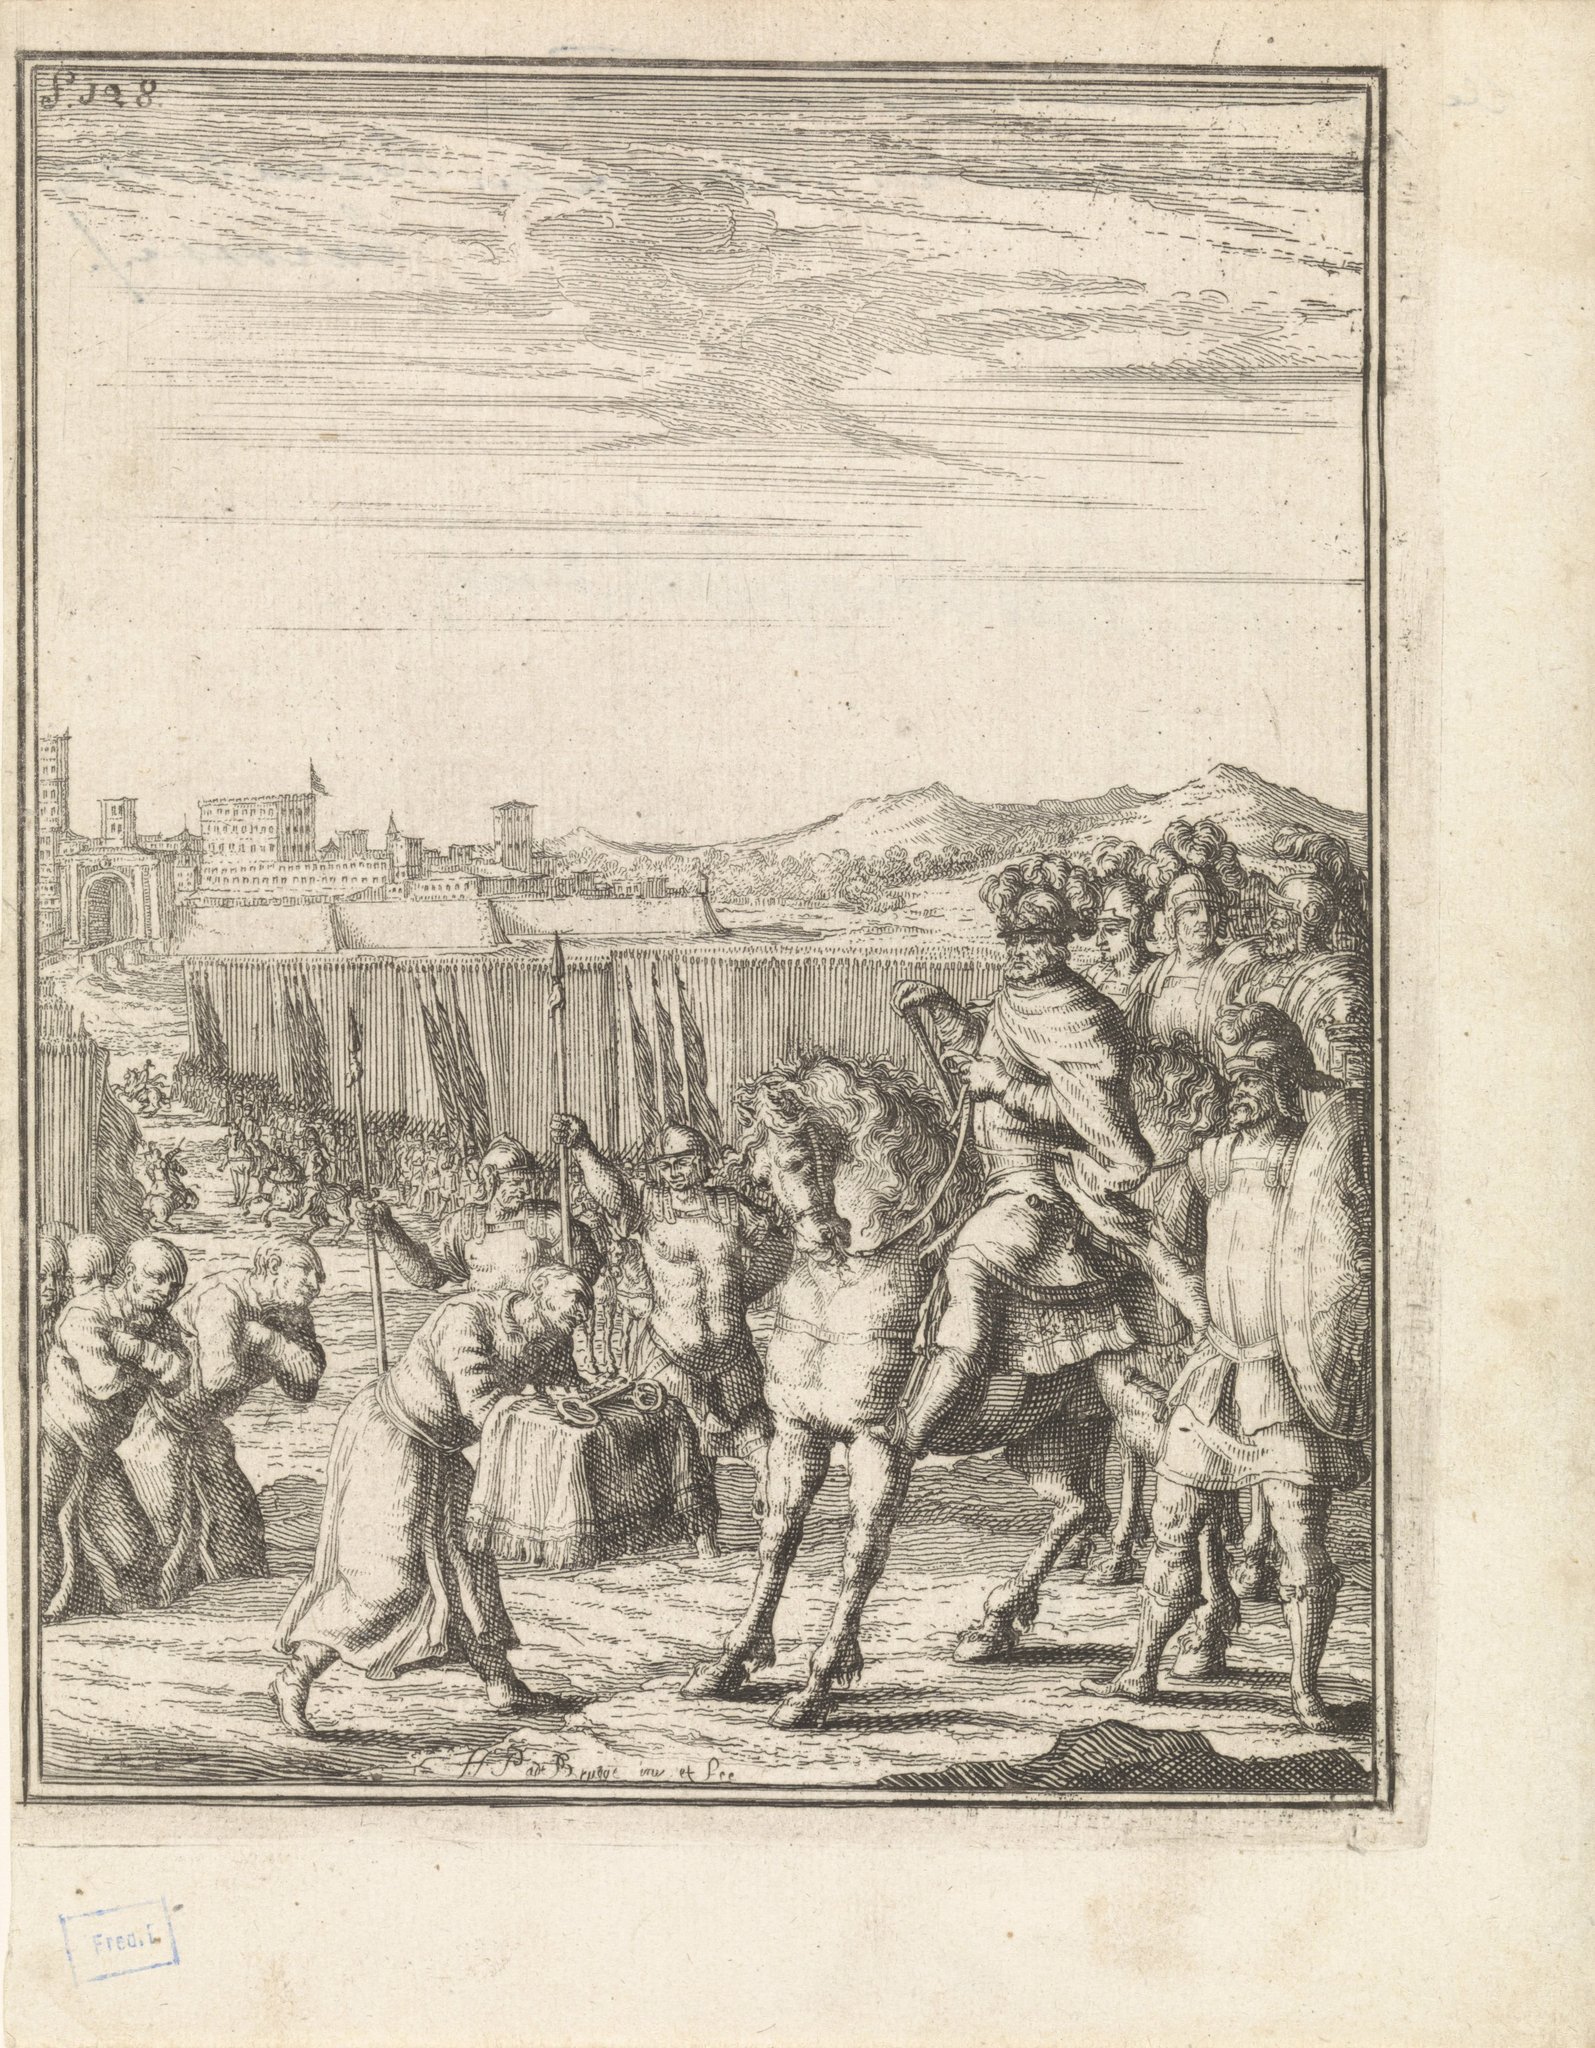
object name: book illustration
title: Verovering van Tunis door keizer Karel V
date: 1676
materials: paper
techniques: engraving, etching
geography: amsterdam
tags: capuche, charles v (holy roman emperor and king of spain), surrender of keys (+ outside city-wall or fortress)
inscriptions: collector's mark: Lugt 2228, inscription: ‘De keizer wordt meester van Tunis / Leven en daden van Horusce en Haread Barbarossa. /.’, collector's mark: Lugt 3761, collector's mark: Lugt 2760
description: Prent gebruikt in: Lambert van den Bos, Leeven en daden der doorluchtighste zee-helden. Amsterdam: Jan Claesz ten Hoorn en Jan Bouman, 1676, dl. I, p. 128/129.